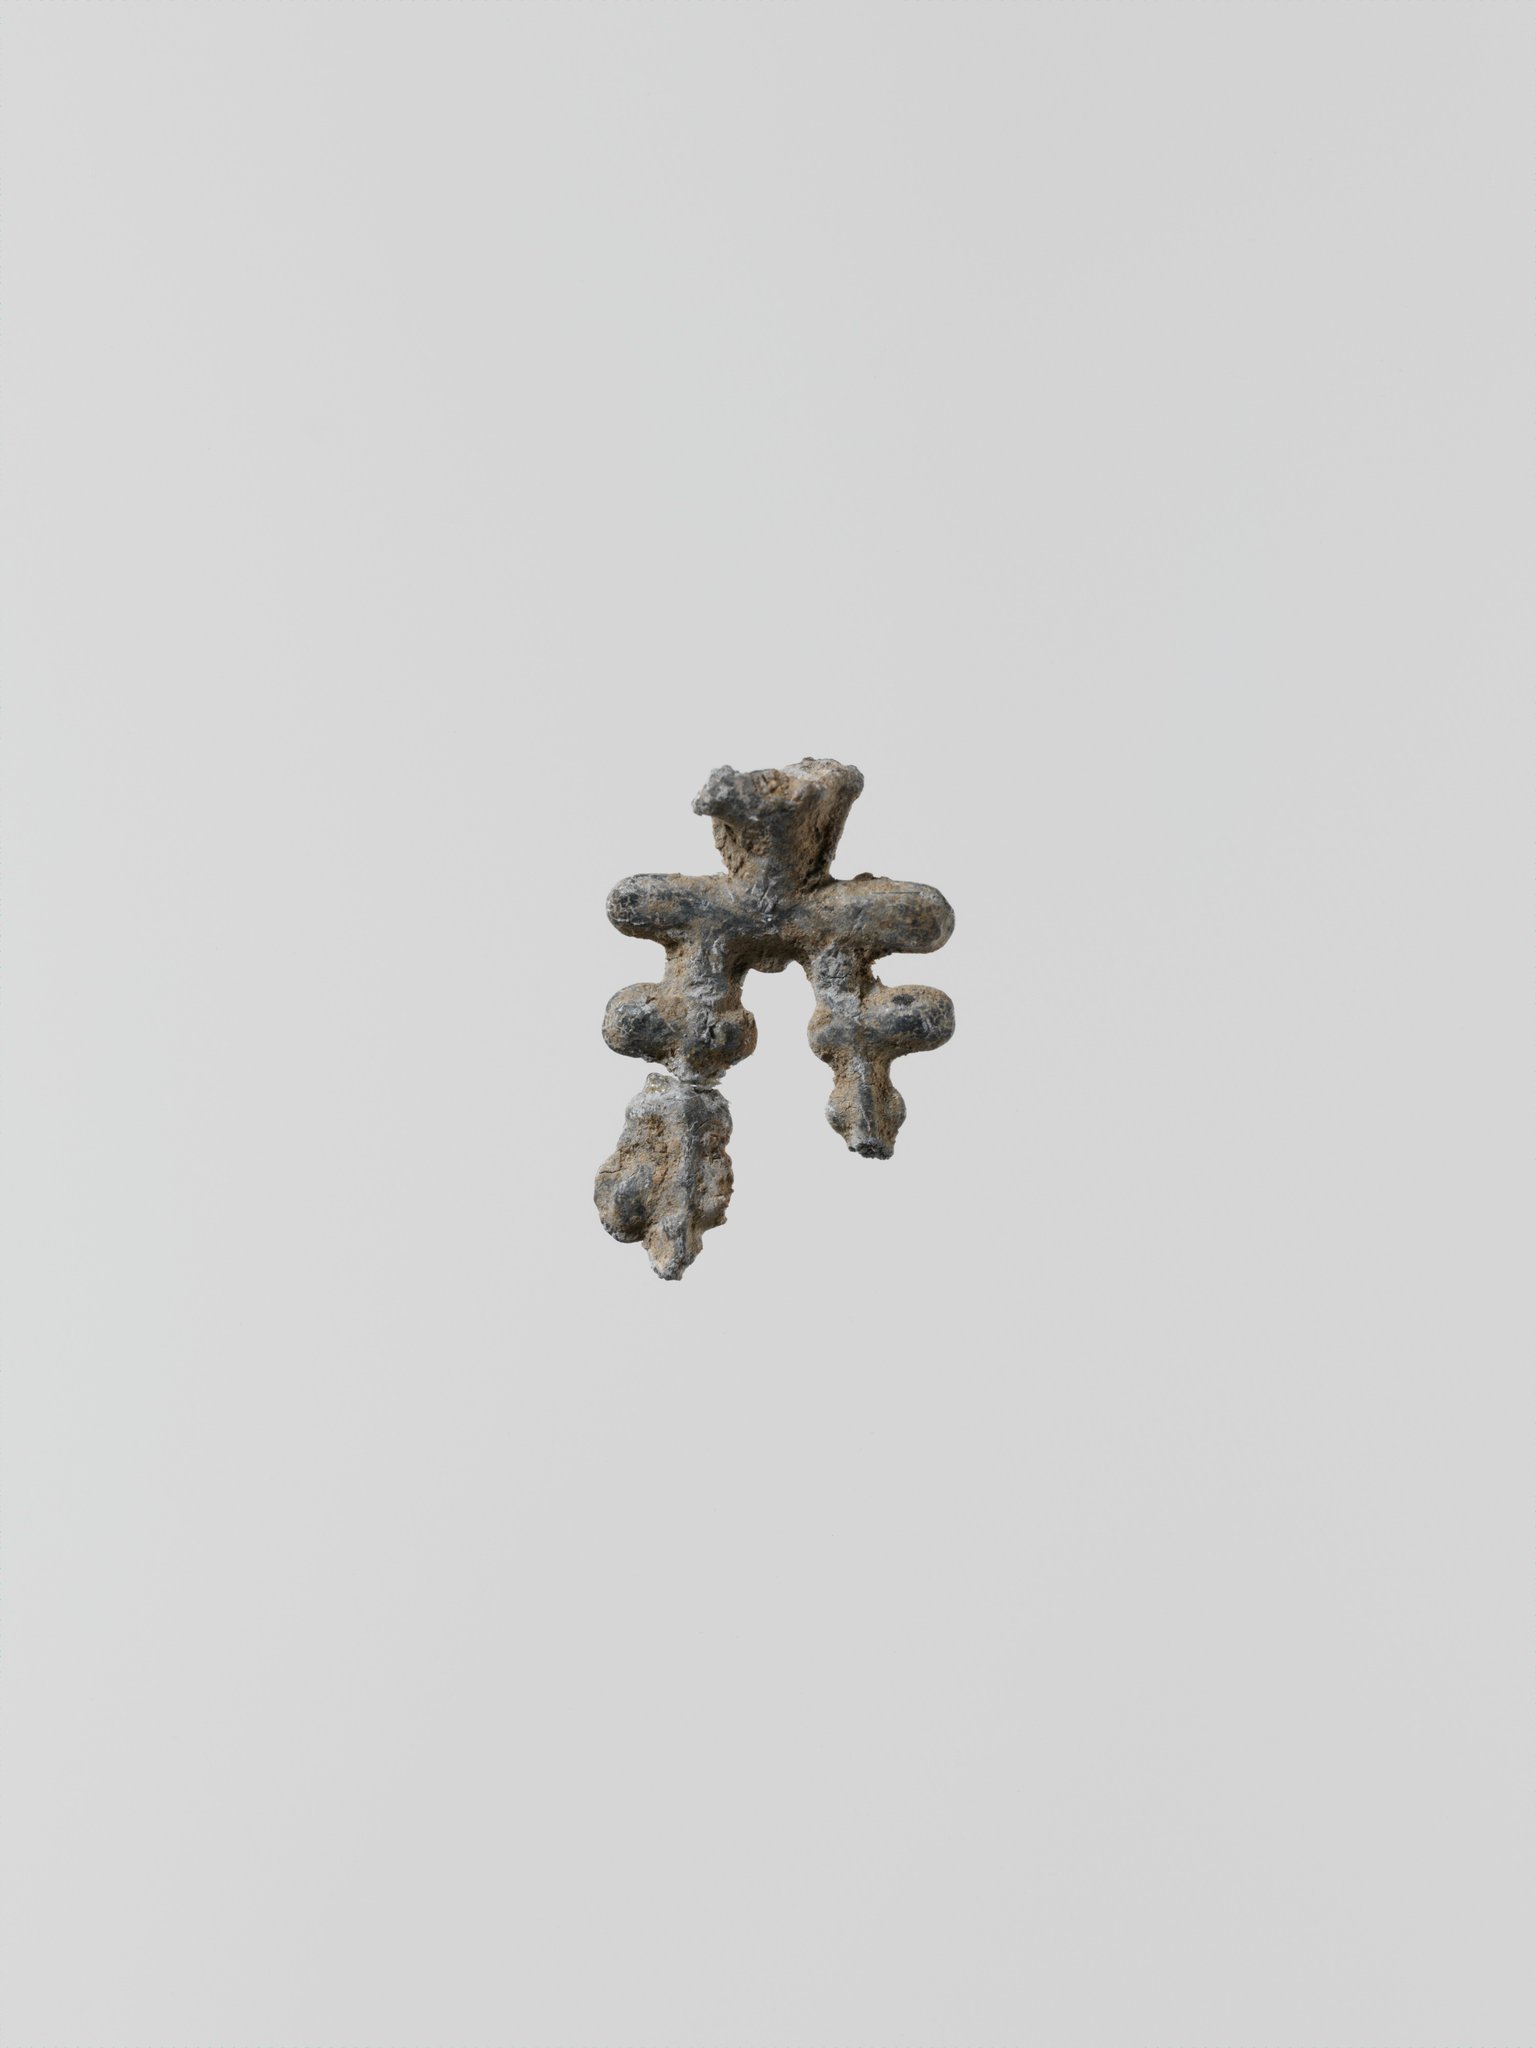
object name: pin, 3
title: Lead ornament, possibly imitating jewelry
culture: greek, laconian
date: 600-401 BCE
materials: lead